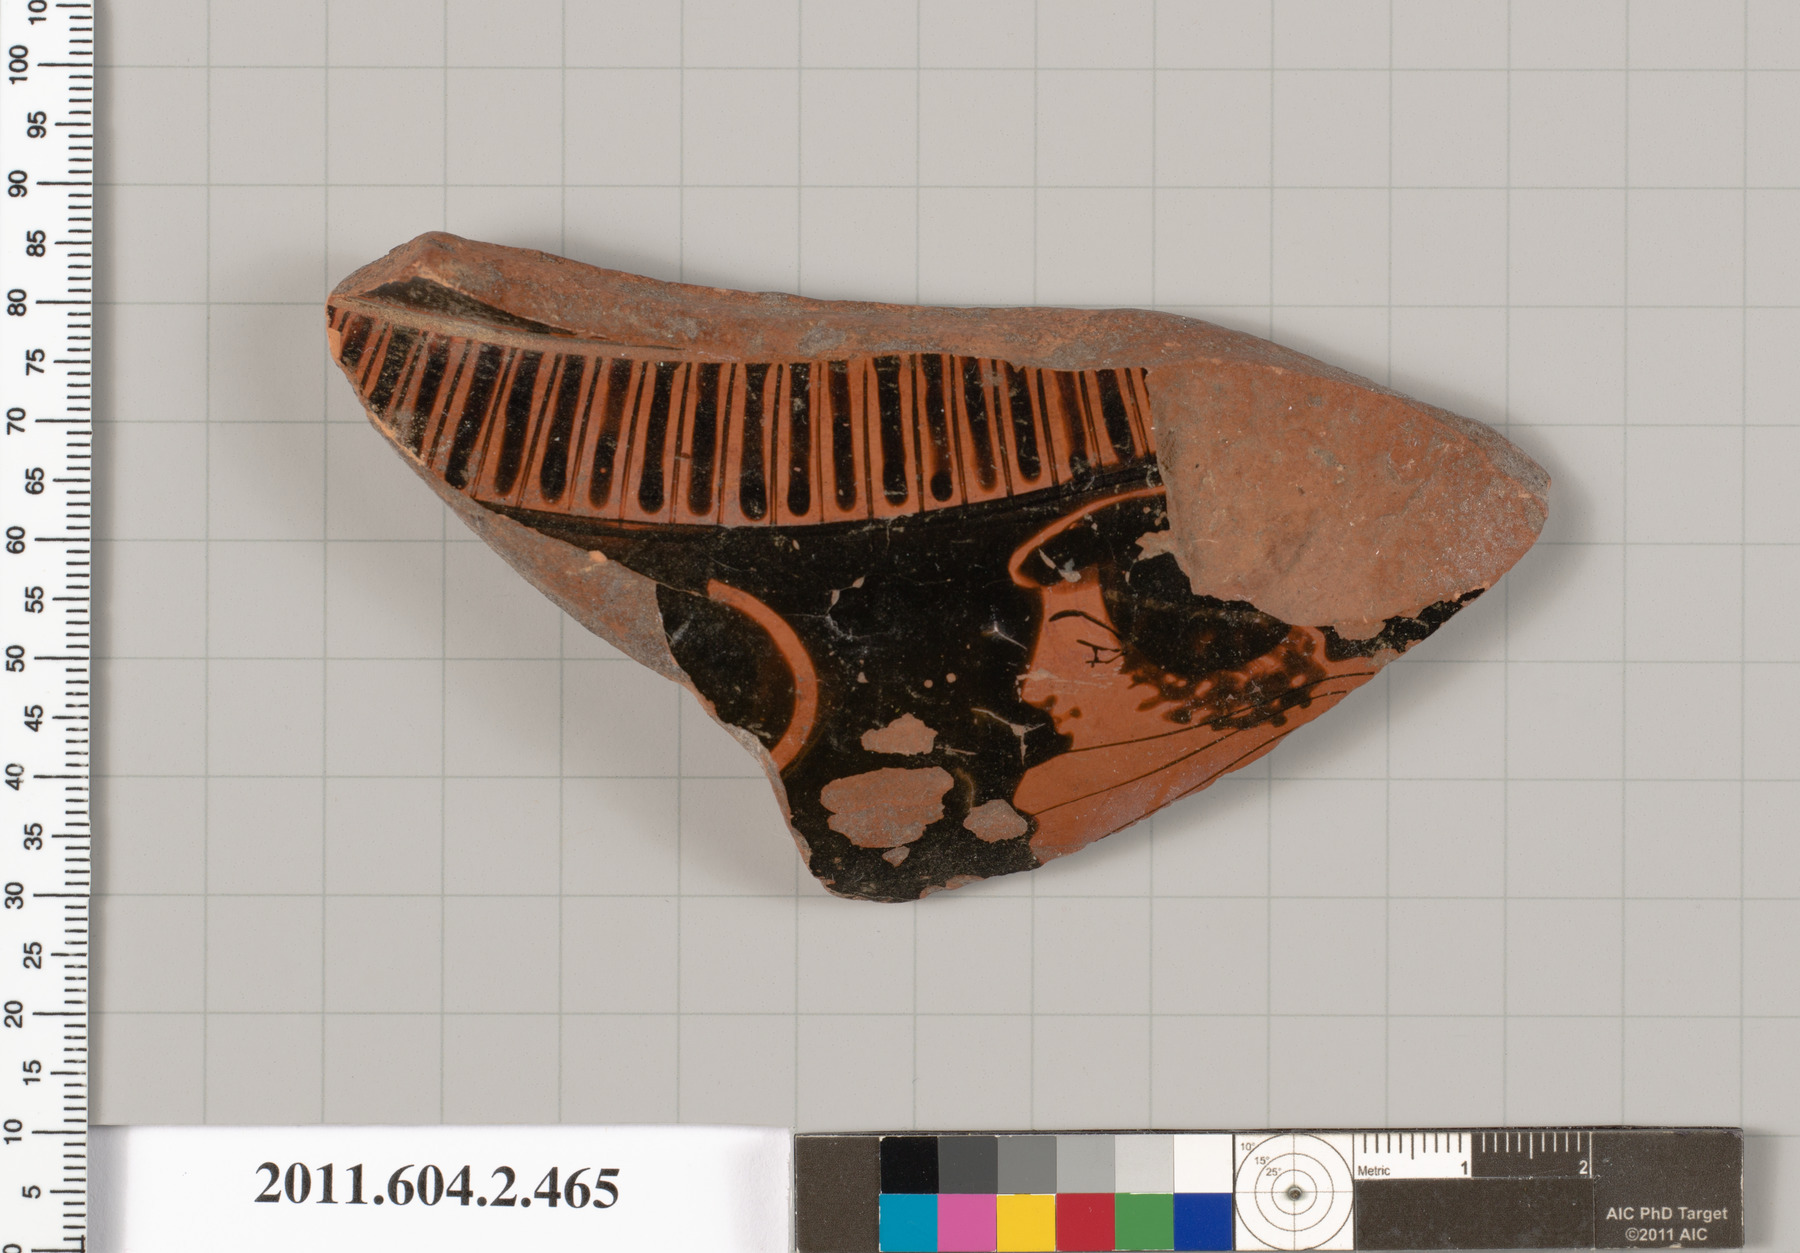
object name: column krater fragment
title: Terracotta fragment of a column-krater (bowl for mixing wine and water)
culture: greek, attic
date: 450-430 BCE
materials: terracotta